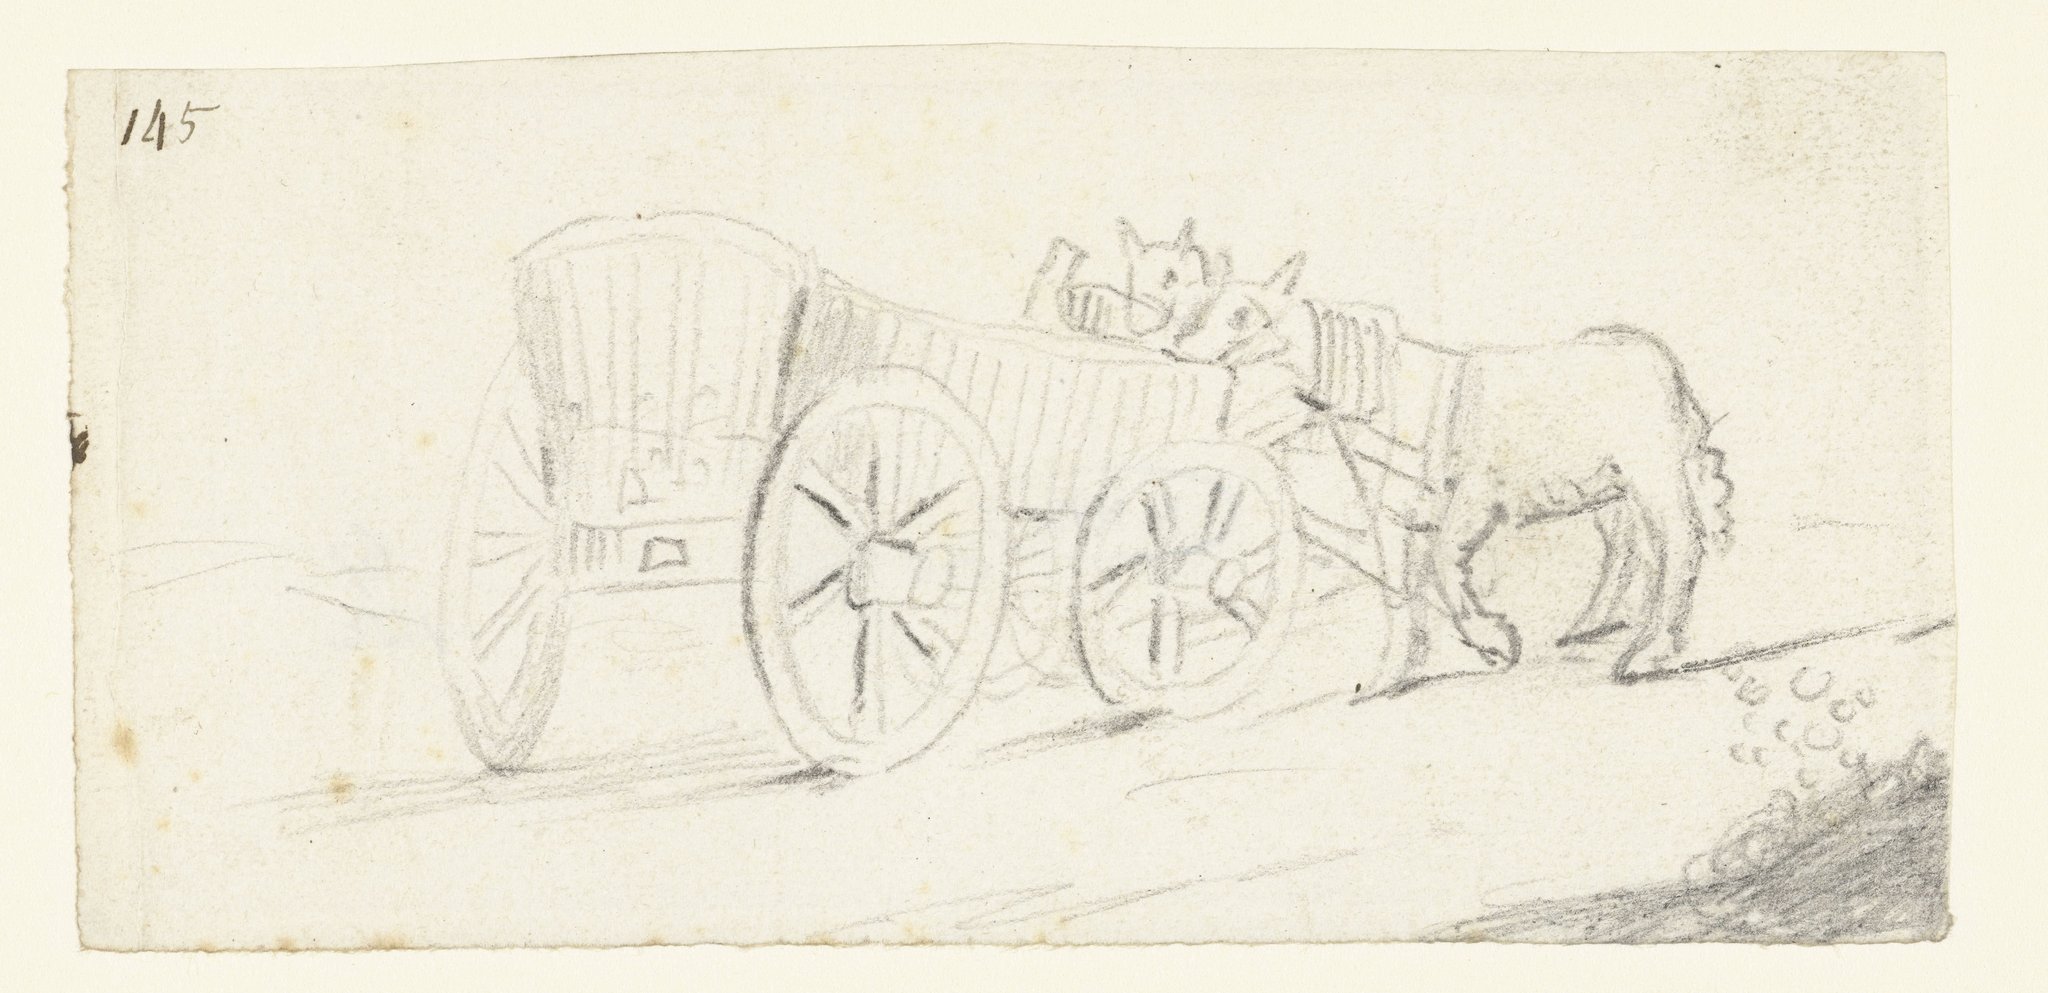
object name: drawing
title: Twee paarden etend bij een wagen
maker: harmen ter borch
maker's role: draughtsman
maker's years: 1638-1677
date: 1647-1648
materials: paper, pencil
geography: zwolle